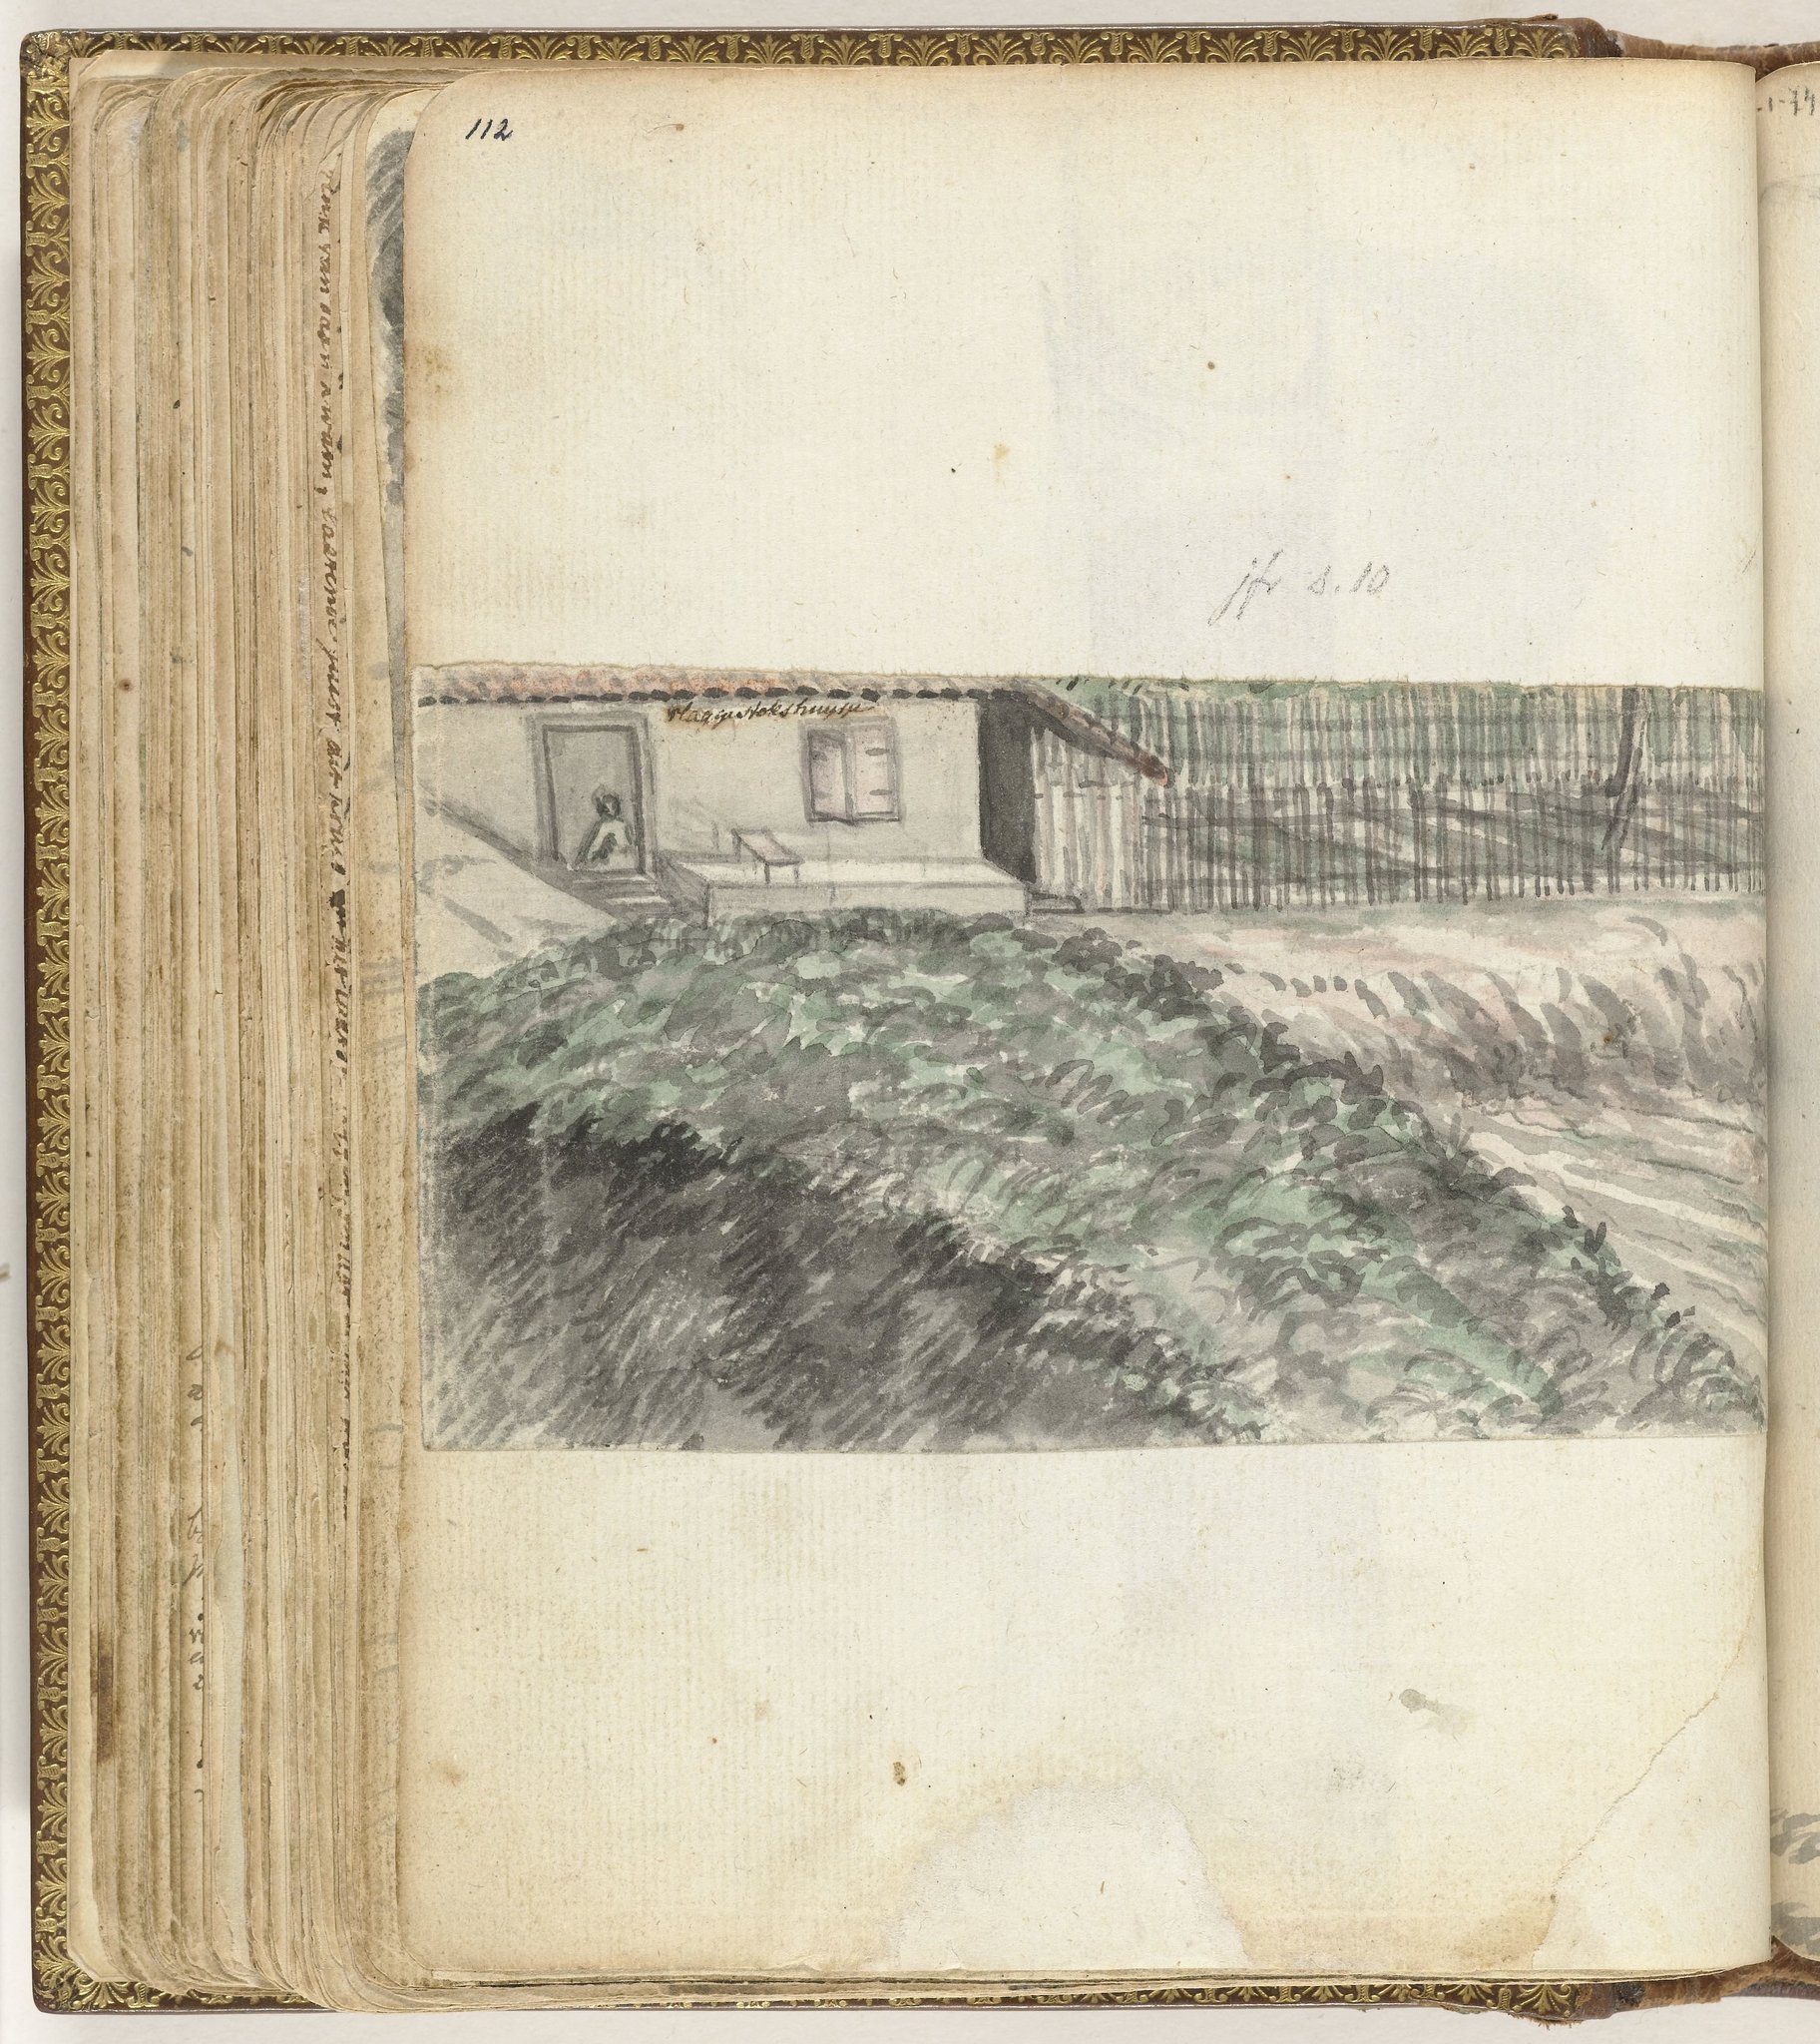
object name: drawing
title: Vlaggestokshuisje te Galle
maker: jan brandes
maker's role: draughtsman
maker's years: 1743-1808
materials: paper, pencil, watercolor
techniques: brush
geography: galle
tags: farm or solitary house in landscape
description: Kleurtekening van een deel van het vlaggestokshuisje. Zie deel 1, p. 10 en deel 2, pp. 149-150. Met opschrift. Onderdeel uit het schetsboek van Jan Brandes, dl. 1 (1808), p. 112.